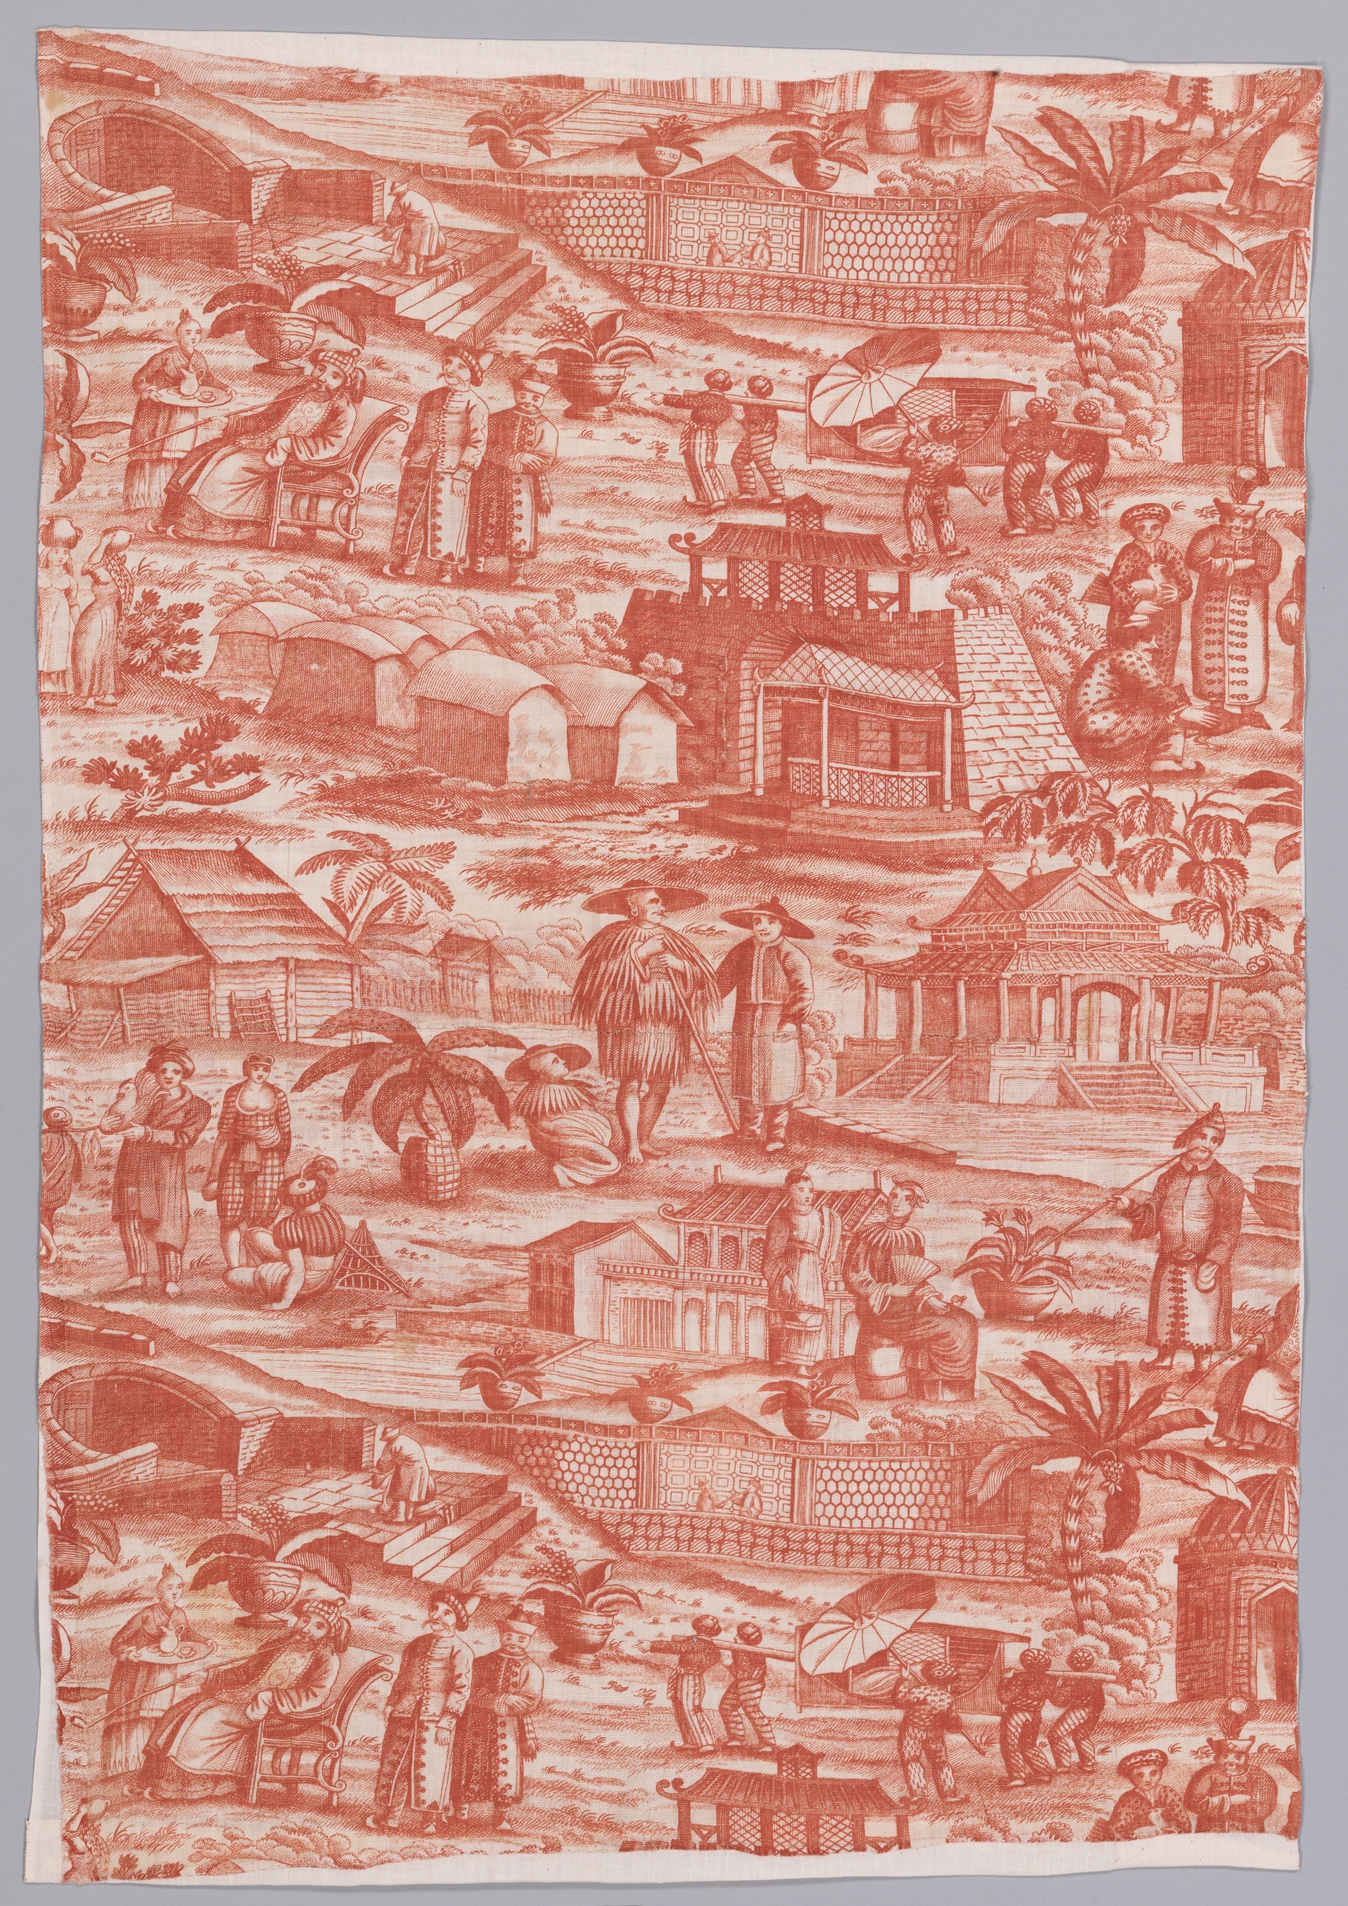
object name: piece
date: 1820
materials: cotton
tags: houses,men,plants